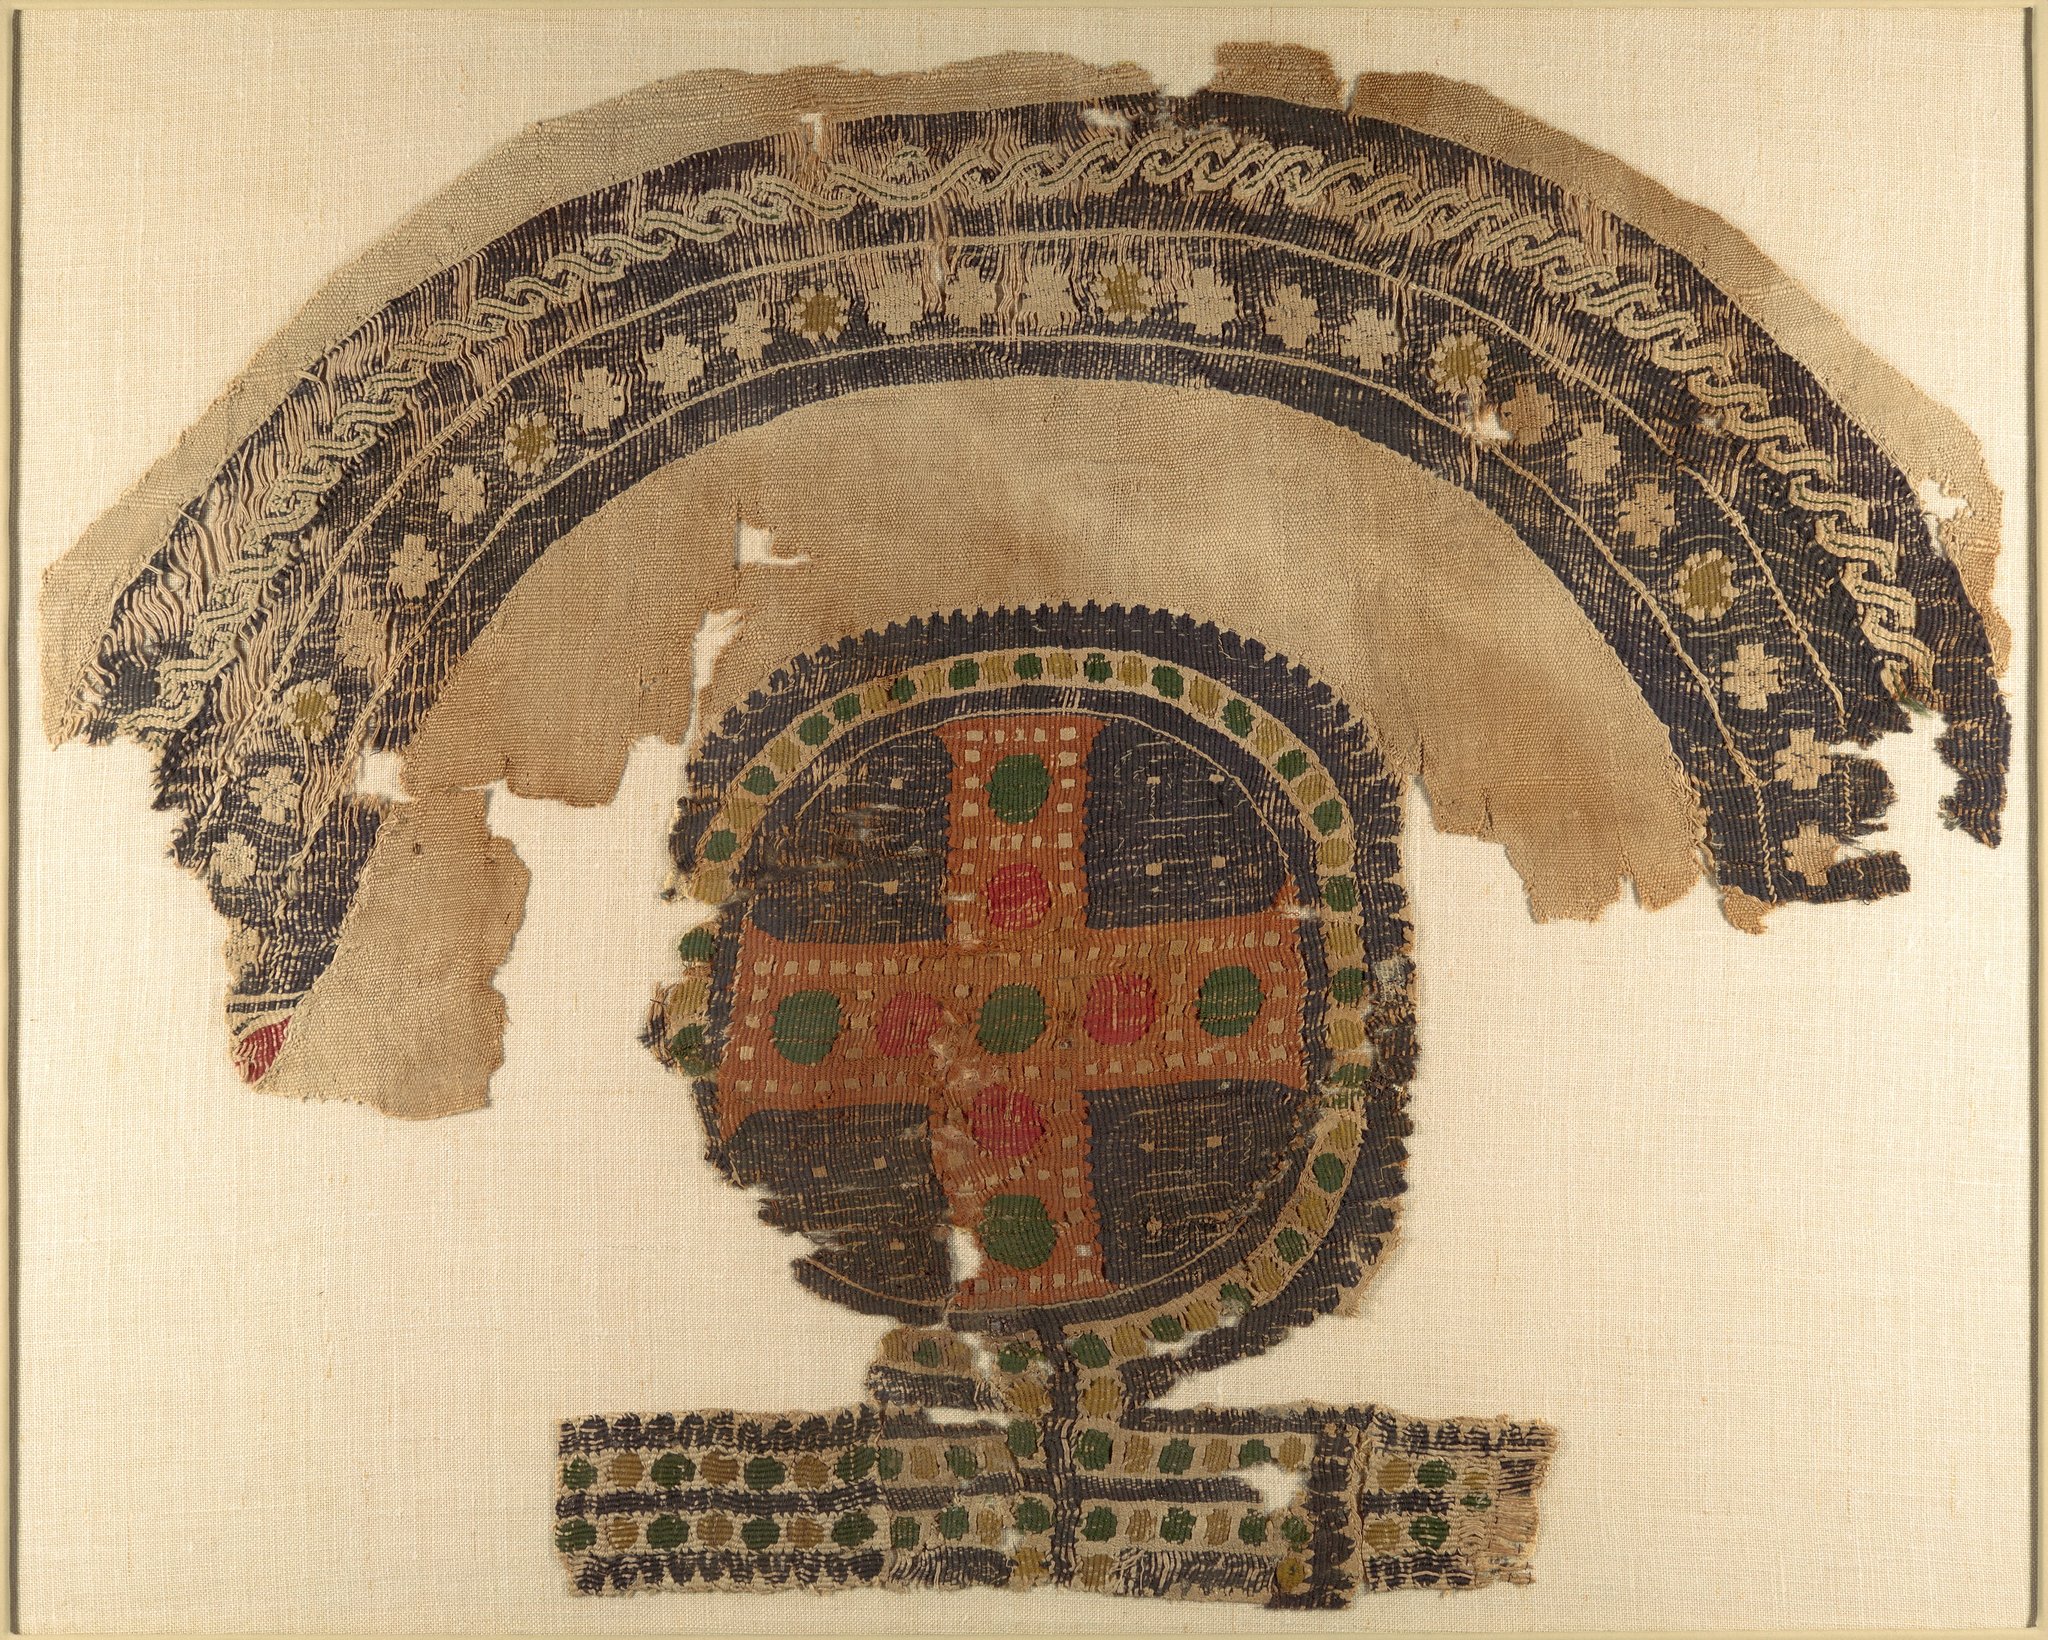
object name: textile fragment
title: Fragment with an Arch and a Gemmed Cross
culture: byzantine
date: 401-600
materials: linen, wool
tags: cross